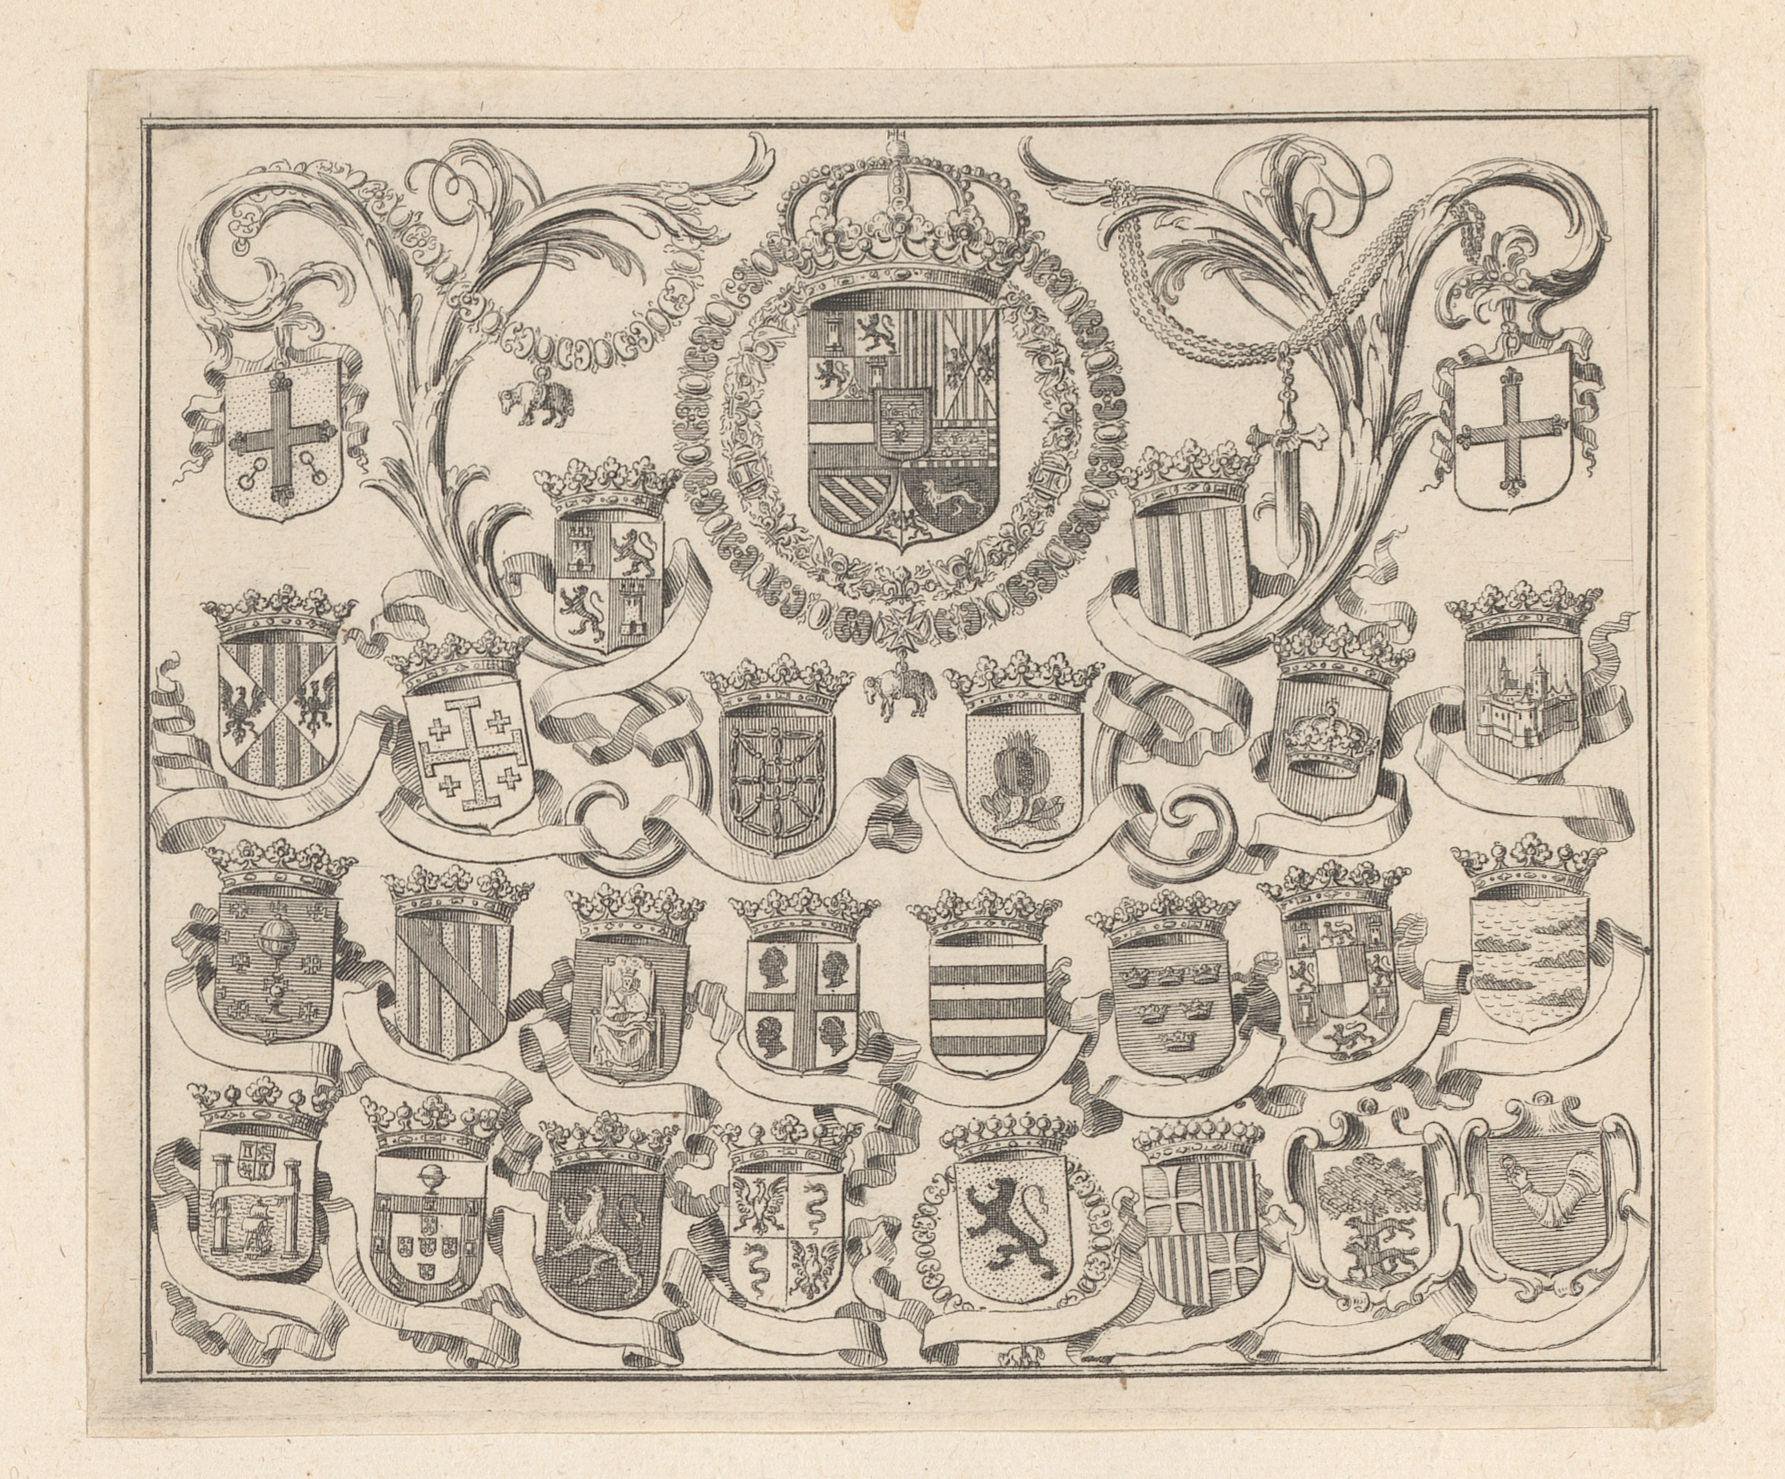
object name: print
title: Verschillende wapenschilden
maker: sébastien leclerc (i)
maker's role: print maker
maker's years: 1637-1714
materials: paper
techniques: etching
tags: armorial bearing, heraldry